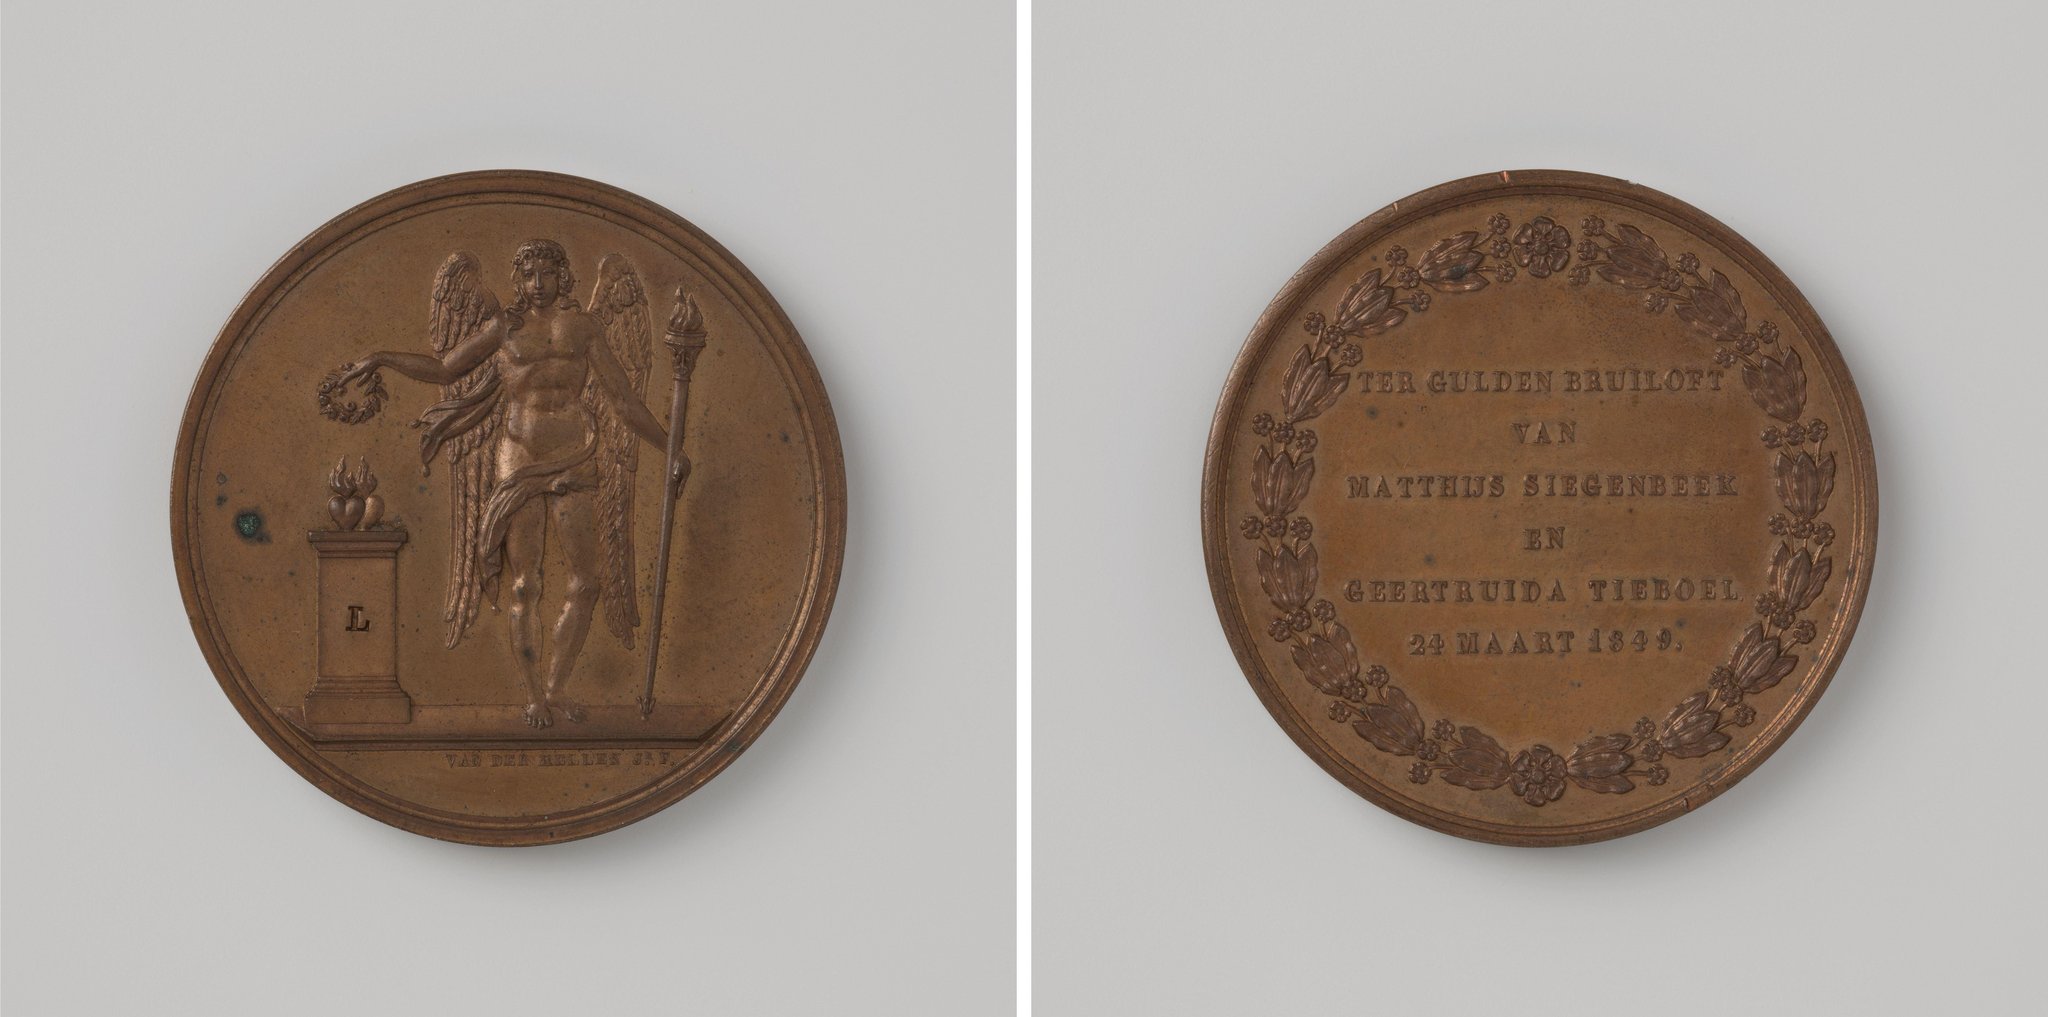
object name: history medal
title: Vijftigjarig huwelijk van Matthijs Siegenbeek en Geertruida Tieboel 1849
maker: david van der kellen (1804-1879)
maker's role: die cutter, draughtsman, print maker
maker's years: 1804-1879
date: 1849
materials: bronze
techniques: striking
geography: utrecht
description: Bronzen penning, op de voorzijde een aanziende gevleugelde genius met lauwerkrans en fakkel bij een altaar, waarop L, met twee brandende harten, op de keerzijde zes regels tekst binnen een mirtenkrans.